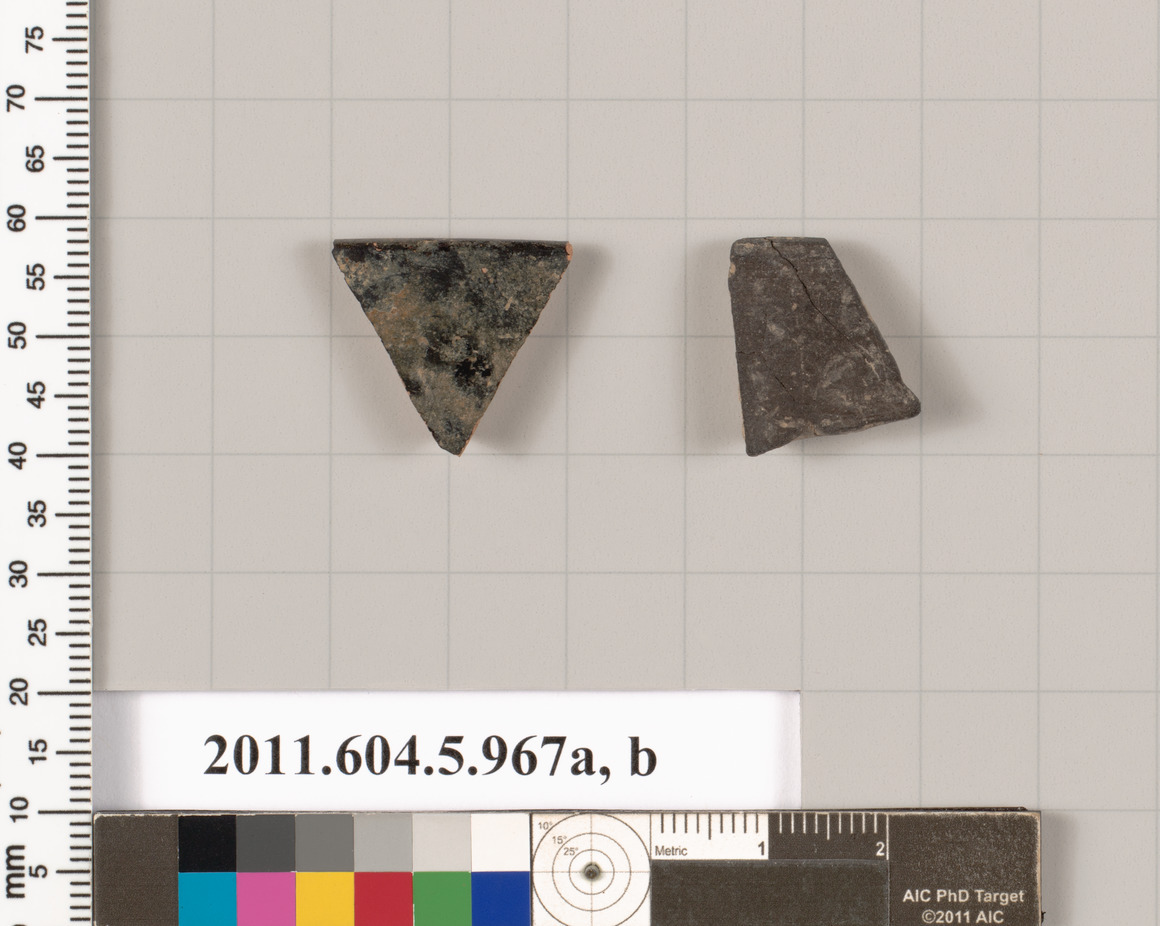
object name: kylix fragment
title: Terracotta rim fragments of kylikes (drinking cups)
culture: greek, attic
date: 600-401 BCE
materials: terracotta